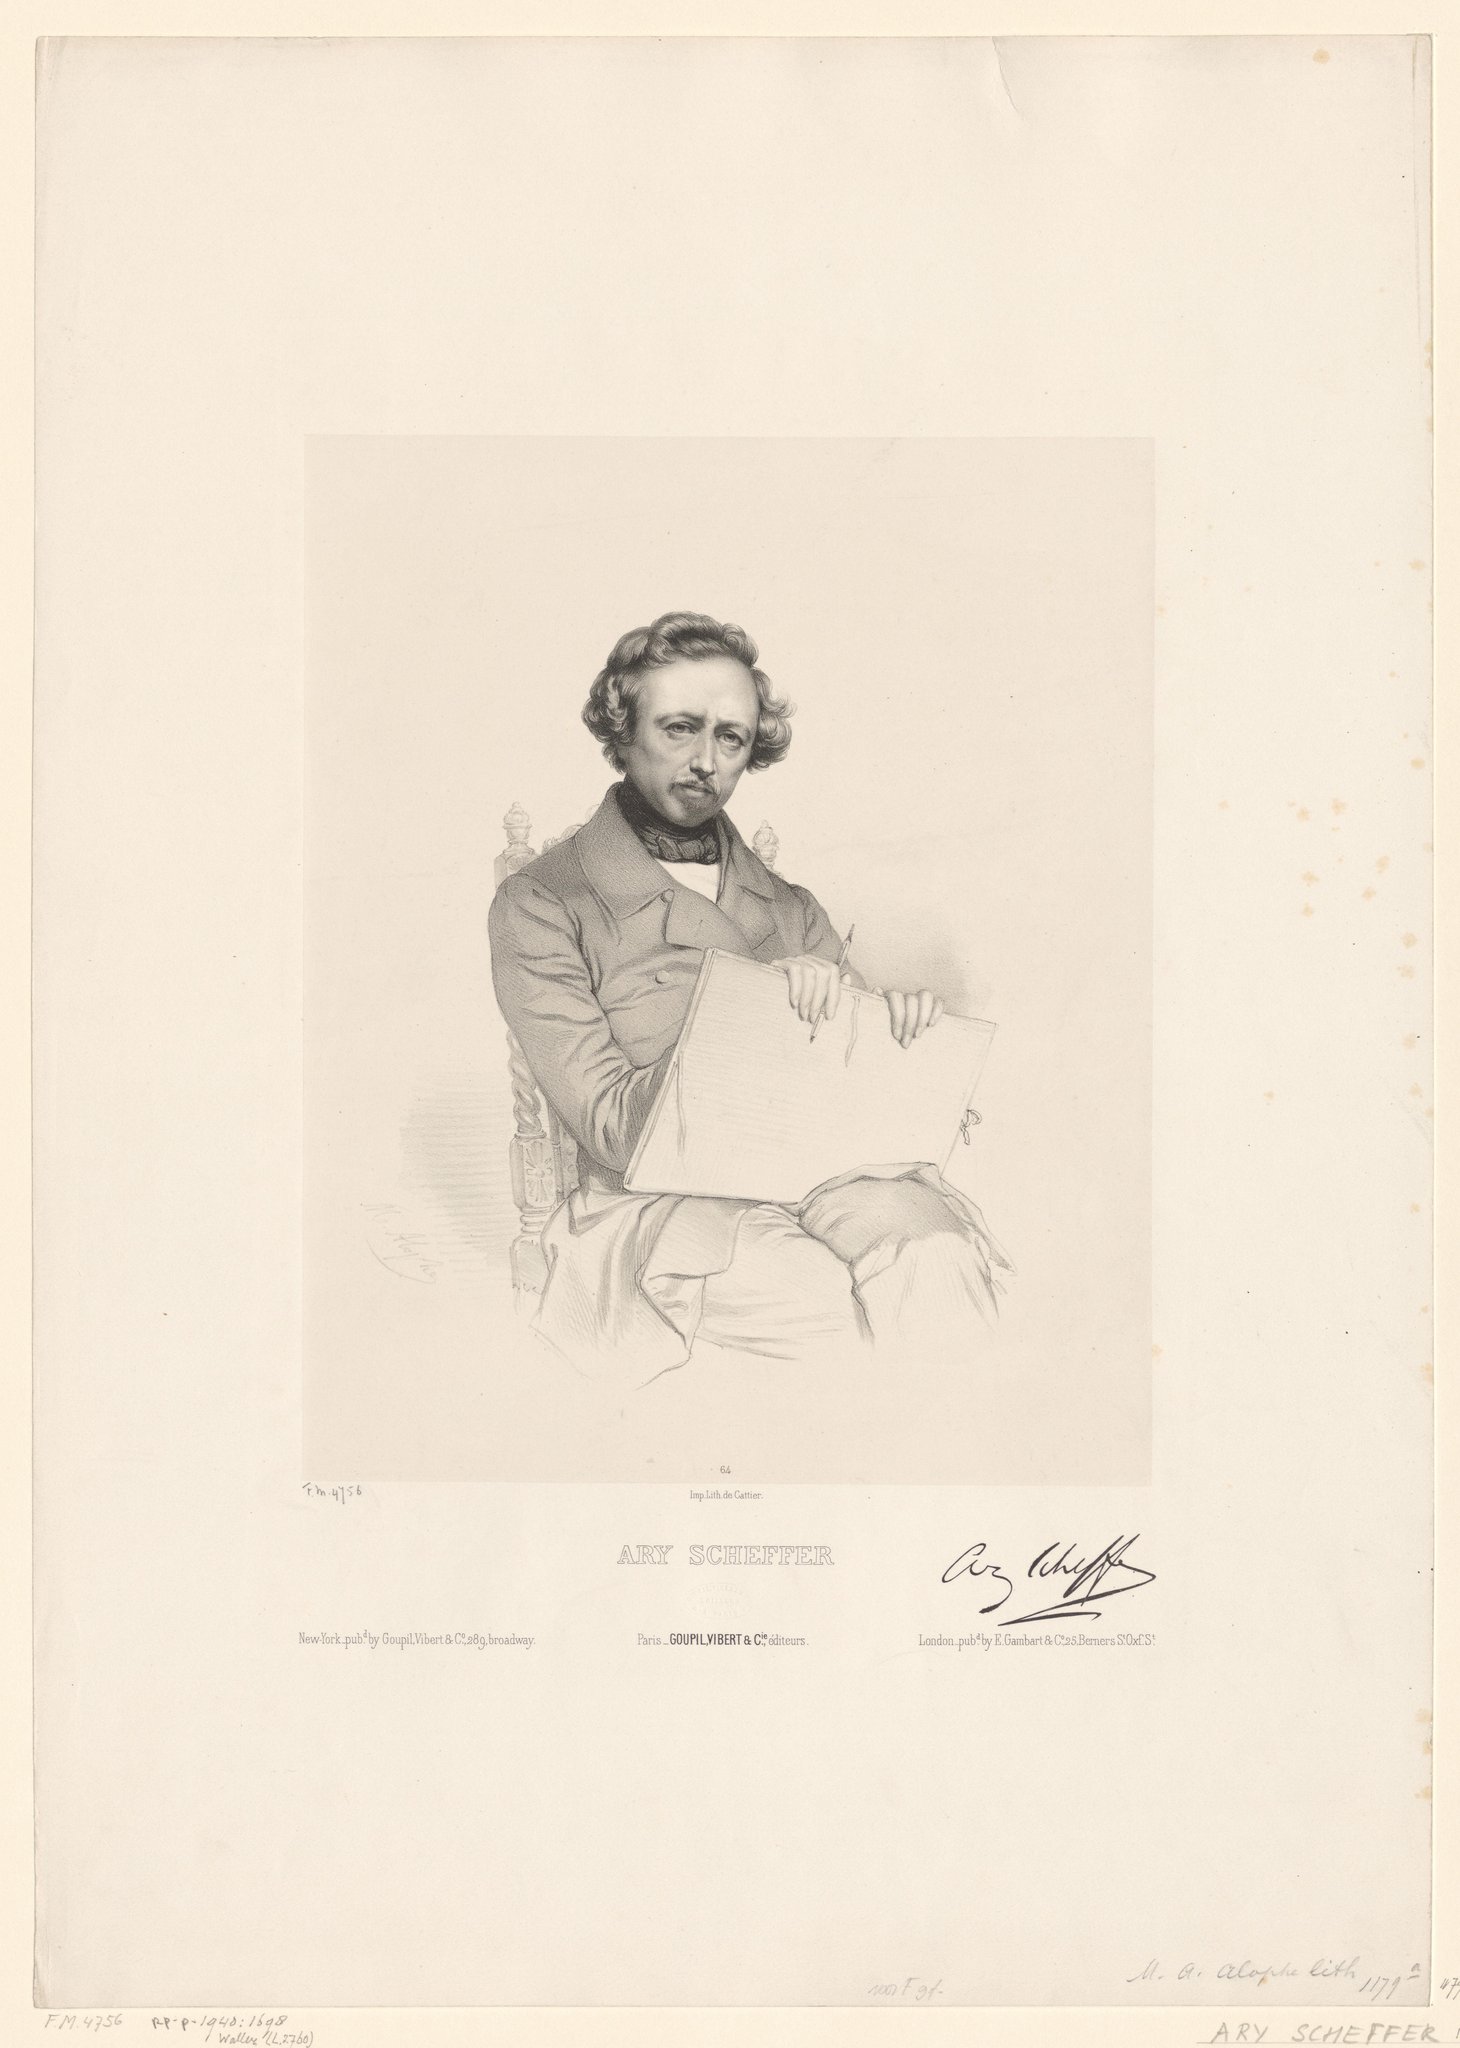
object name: print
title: Ary Scheffer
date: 1848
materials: paper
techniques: lithograph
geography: paris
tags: dordrecht, painter, print maker, draughtsman, sculptor, ary scheffer, historical persons, portrait, self-portrait of artist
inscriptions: collector's mark: Lugt 2166, check stamp: Lugt 5004, collector's mark: Lugt 2760